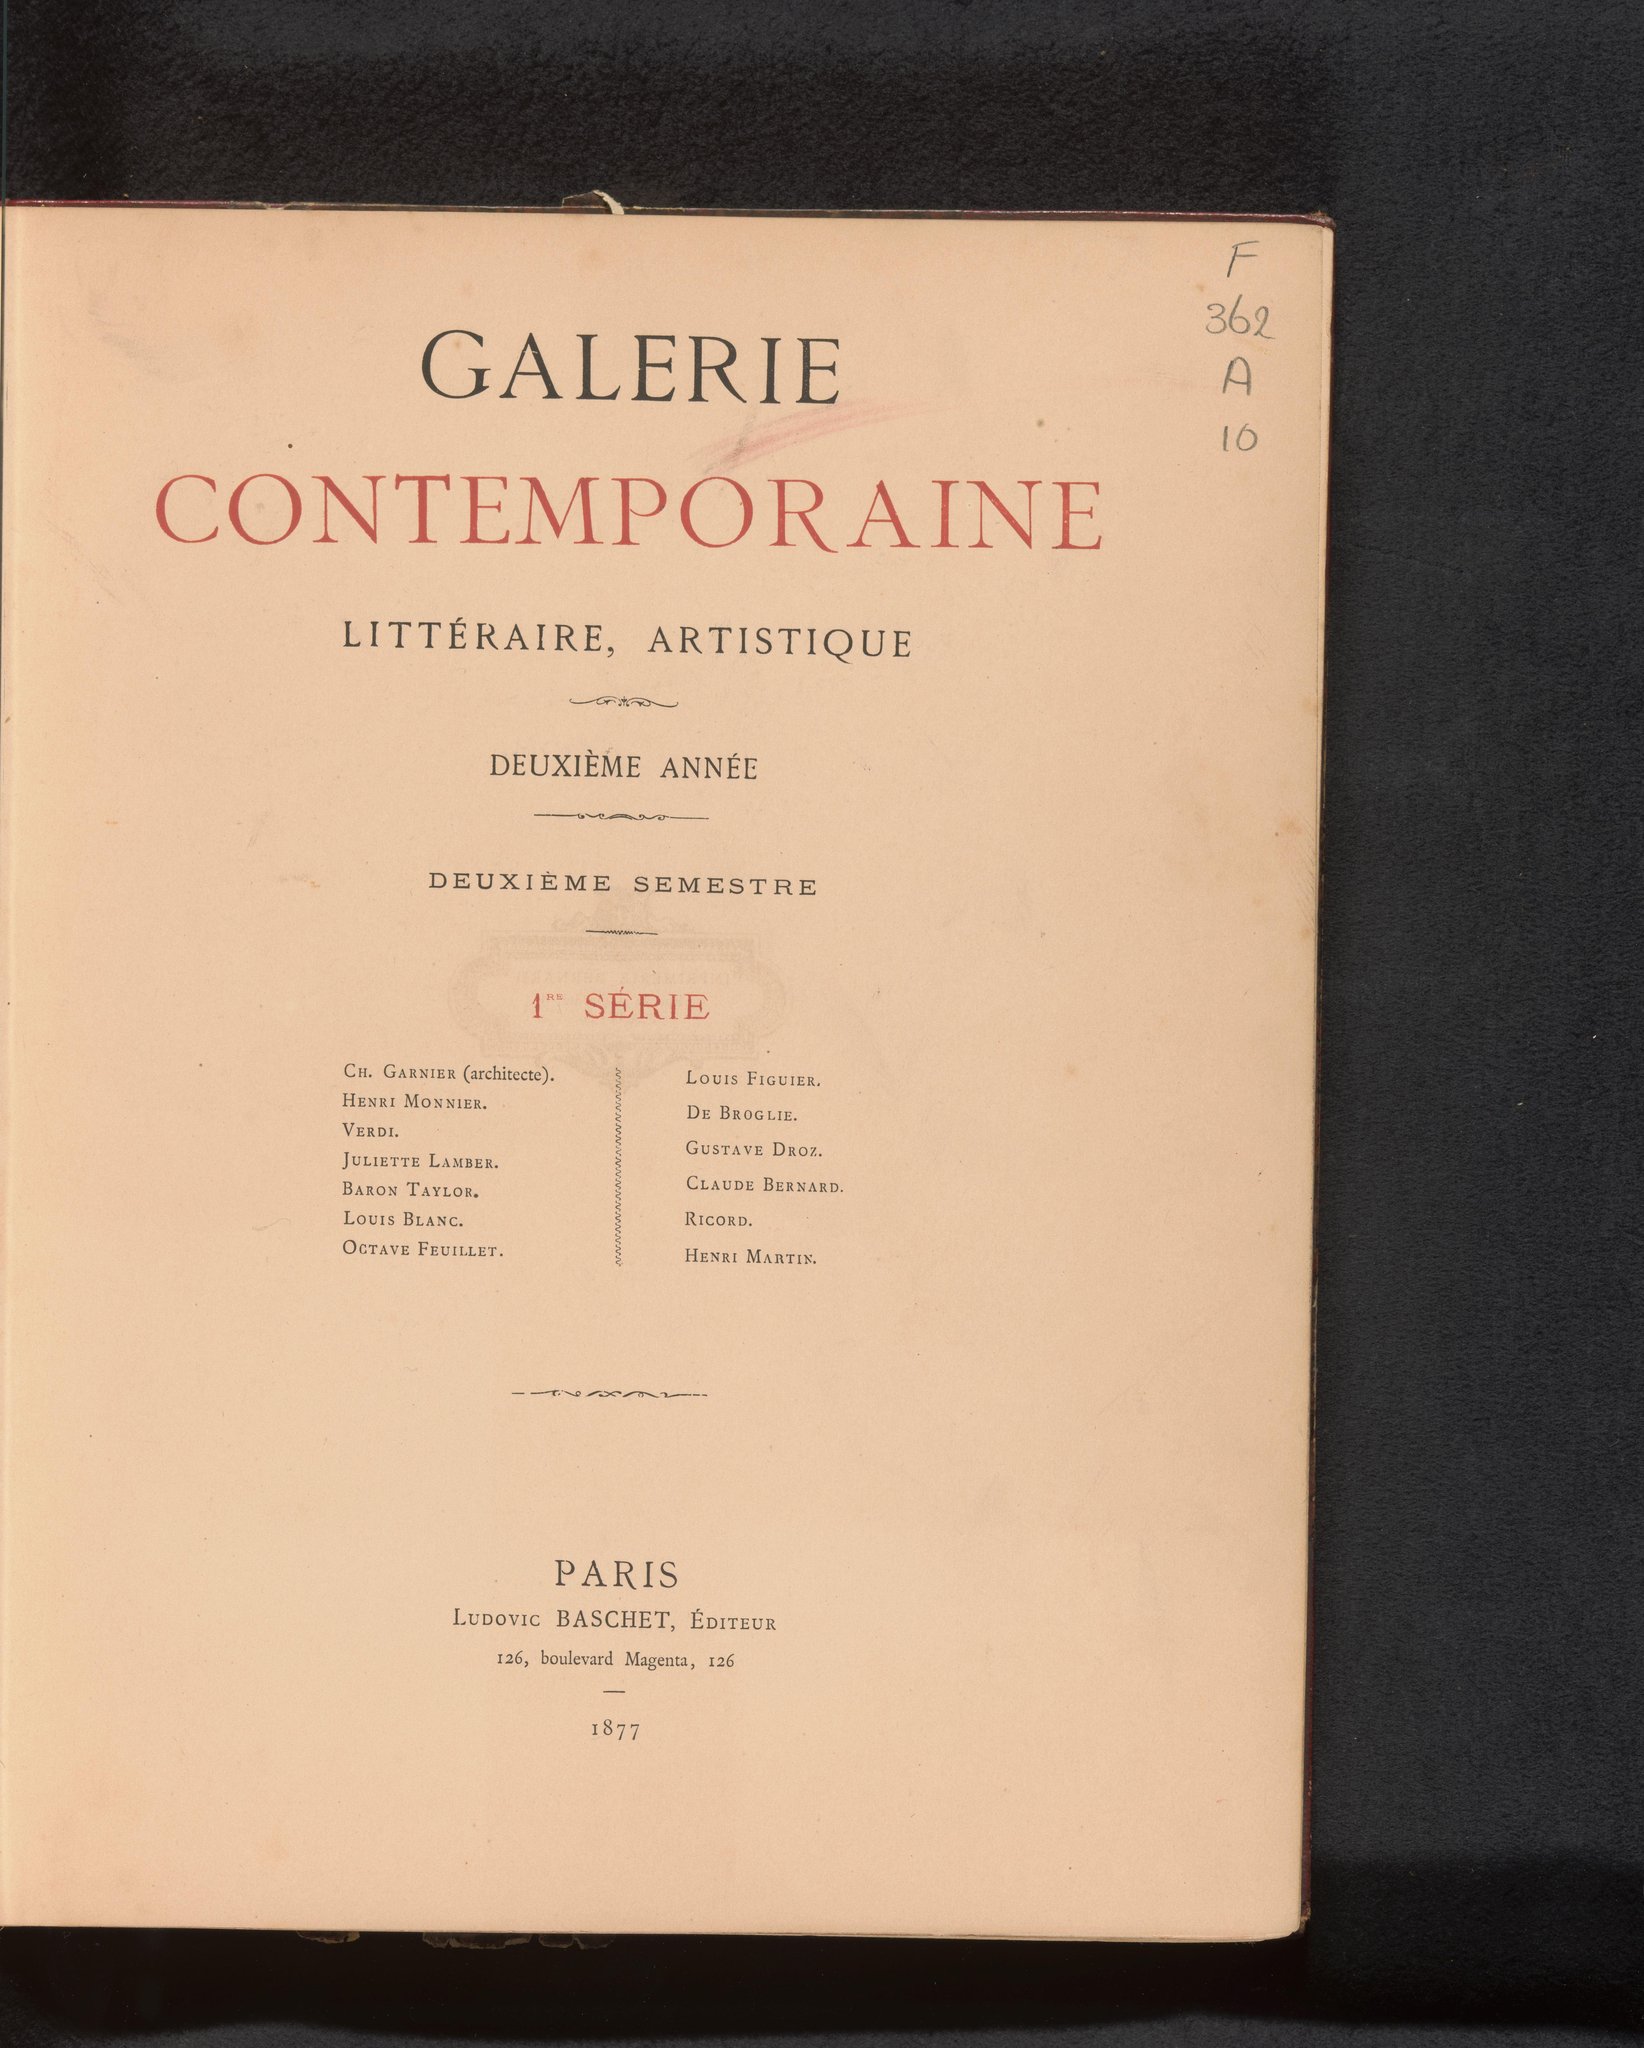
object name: book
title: Galerie contemporaine : litteraire, artistique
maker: ludovic baschet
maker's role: publisher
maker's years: 1834-1909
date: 1877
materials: paper, photographic support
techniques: marbled paper, printing, printing block, woodburytype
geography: paris